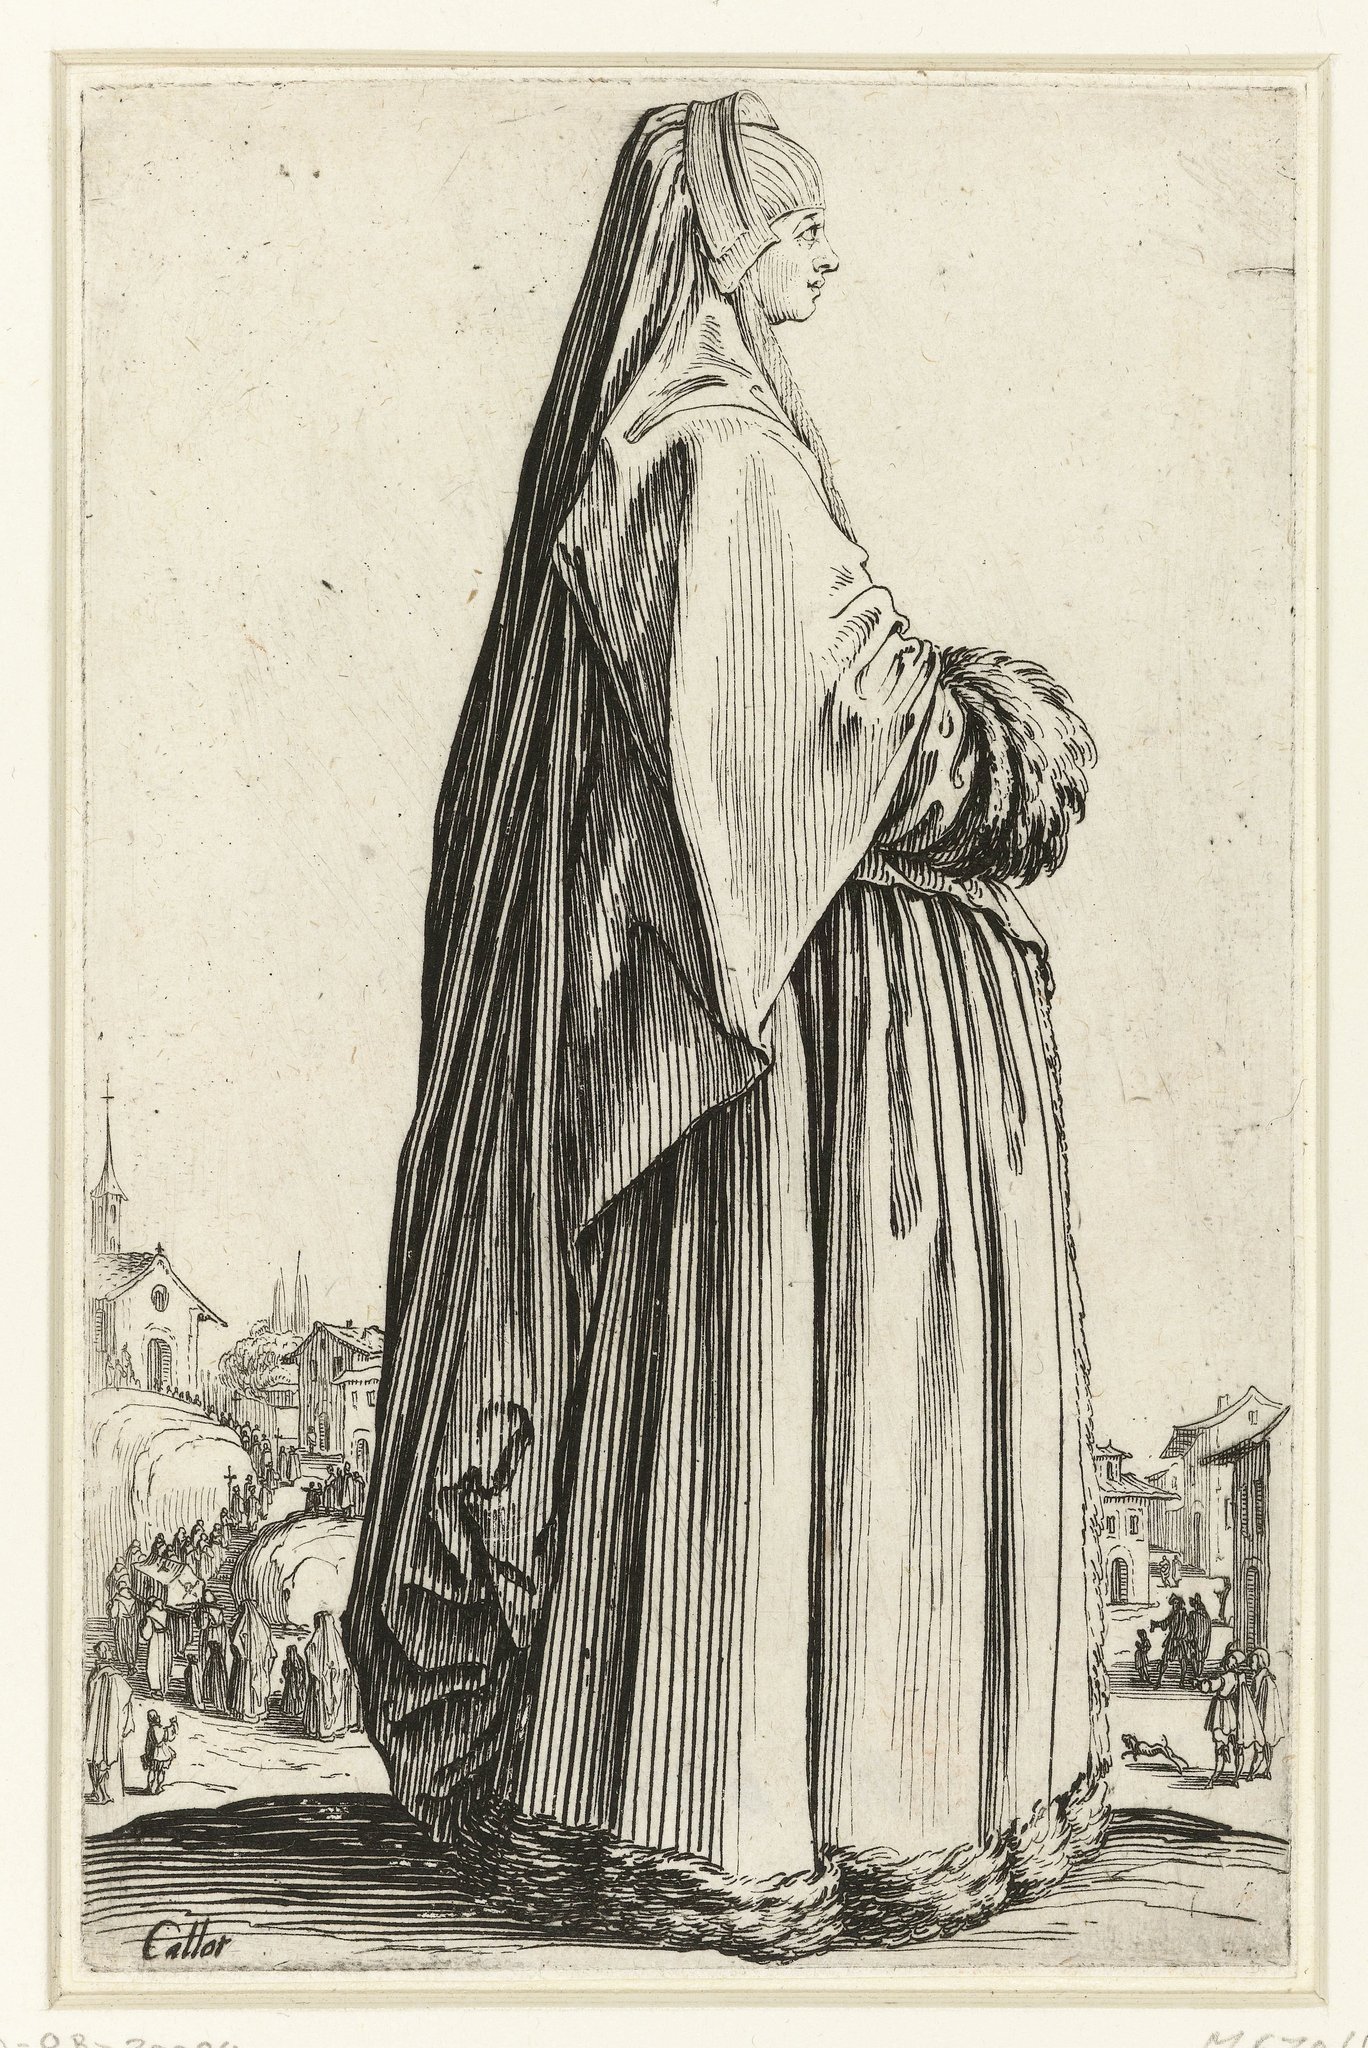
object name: costume print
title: Dame met rouwsluier en mof, op de rechterzijde gezien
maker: jacques callot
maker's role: draughtsman, print maker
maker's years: 1592-1635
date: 1620-1623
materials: paper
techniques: etching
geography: nancy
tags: veil (+ women's clothes), clothes, costume (+ women's clothes), skirt (+ women's clothes), dress, gown (+ women's clothes), mourning dress, muff (+ women's clothes), nobility and patriciate; chivalry, knighthood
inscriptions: collector's mark: Lugt 240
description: Kapje met lange huik ( of soort ondermuts) Lijf met spits toelopend schootje. Overkleed met bontrand. . Mof.